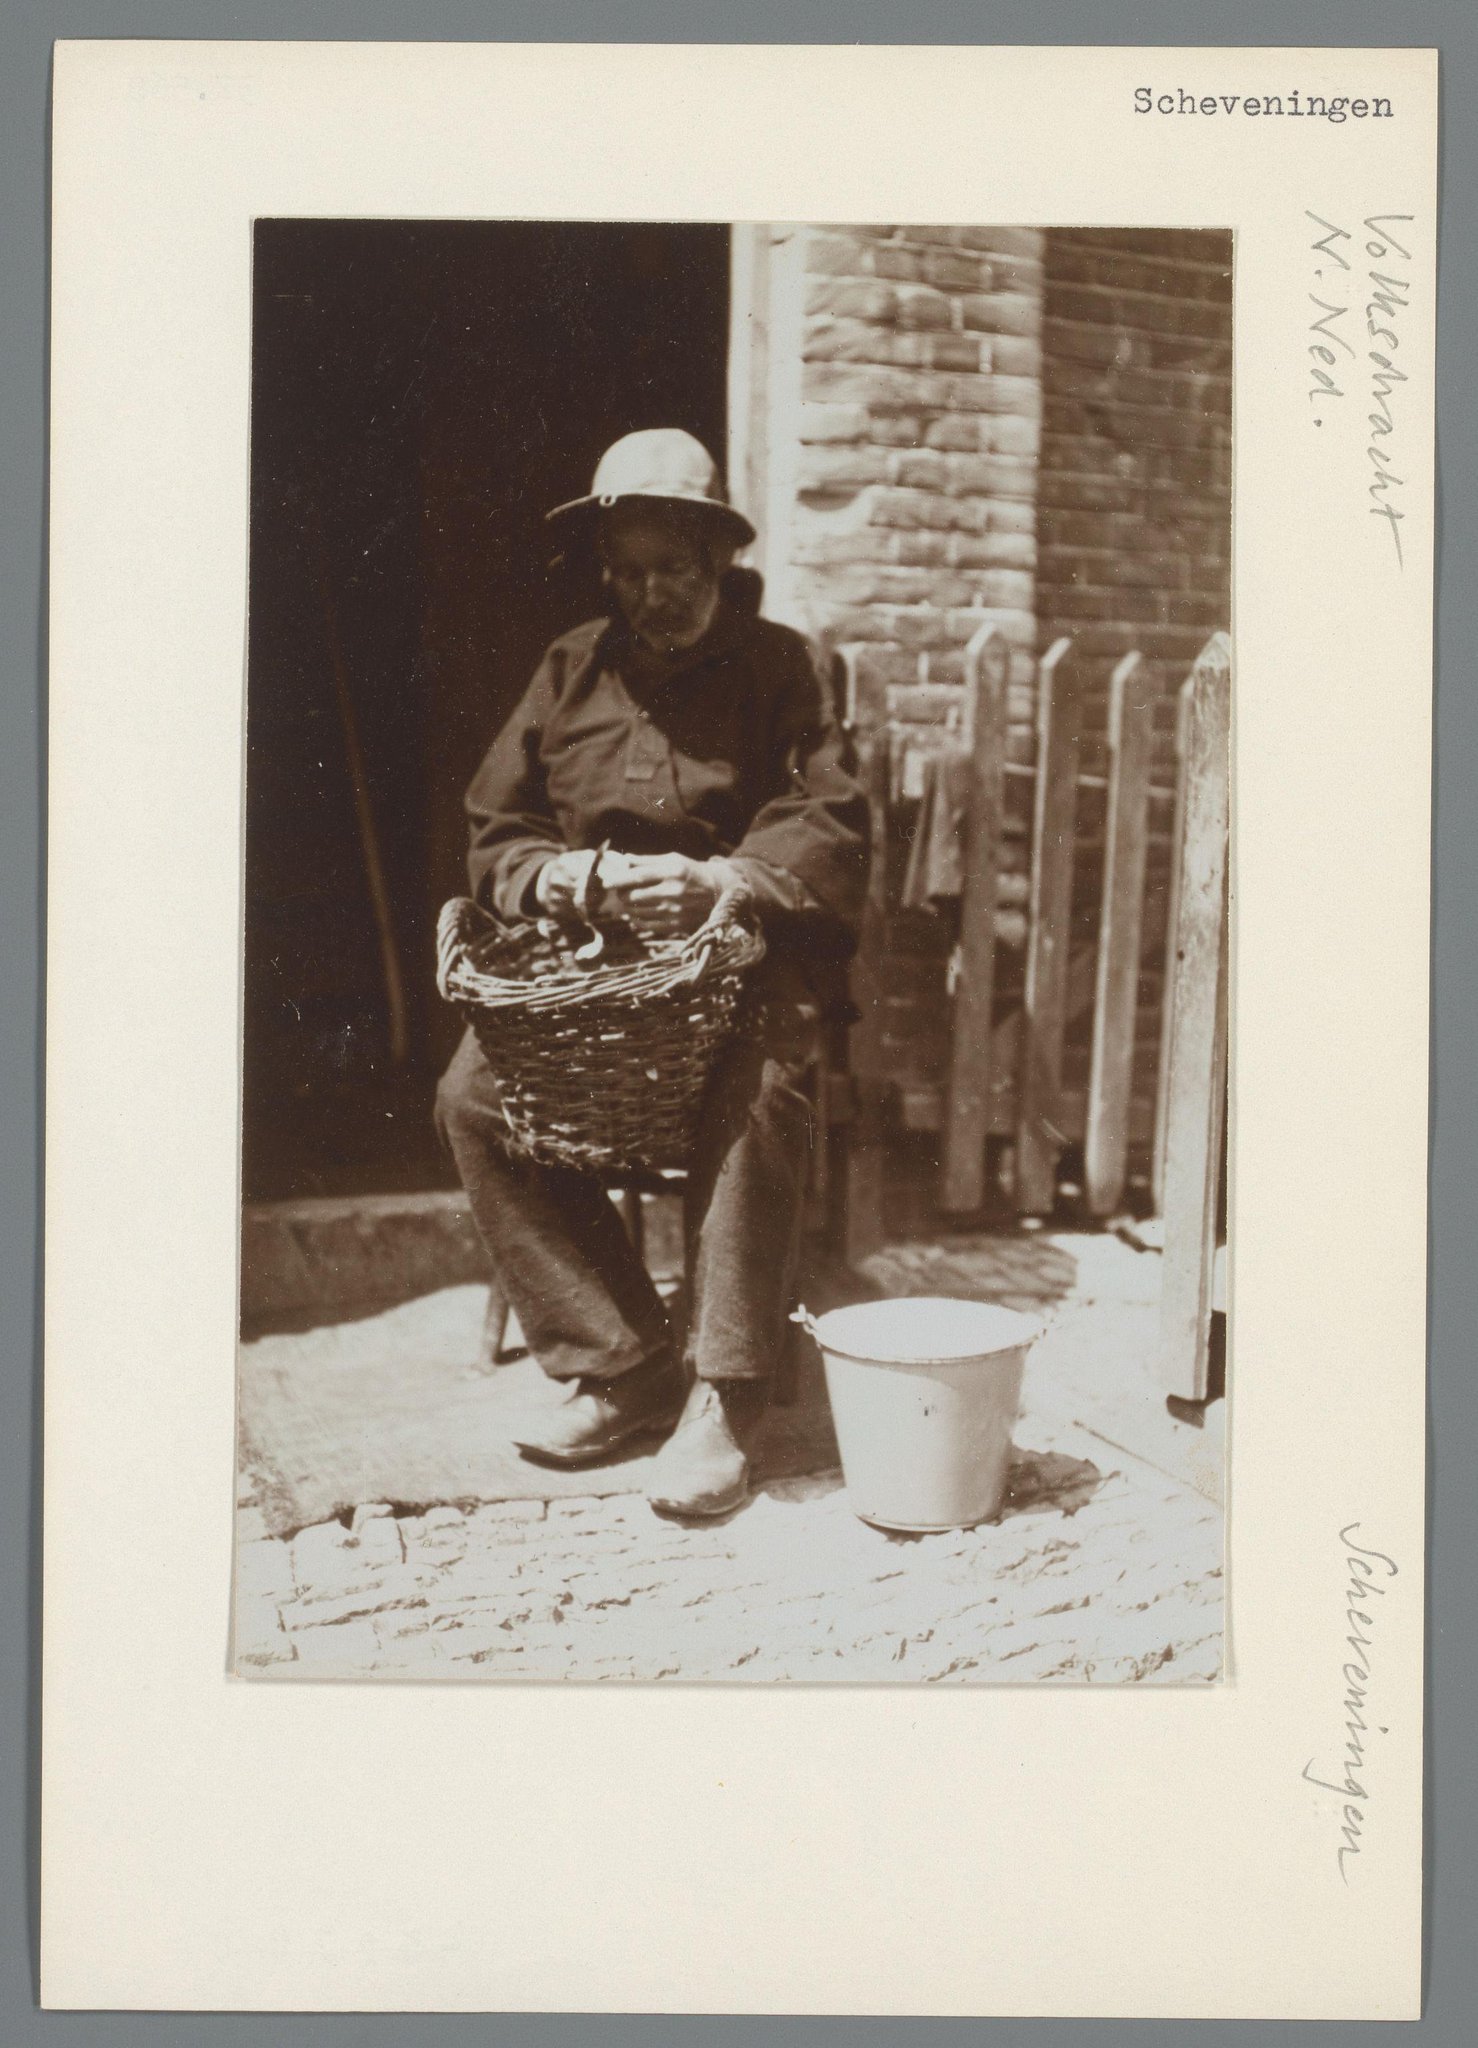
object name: photograph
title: Portret van een onbekende man in Scheveningse dracht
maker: Anonymous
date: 1880-1920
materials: paper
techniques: collodion silver print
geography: scheveningen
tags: historical persons, folk costume, regional costume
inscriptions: inscription: ‘Volksdracht/ N.Ned./ Scheveningen’, inscription: ‘Scheveningen’, number: ‘32.568’, number: ‘-527066’